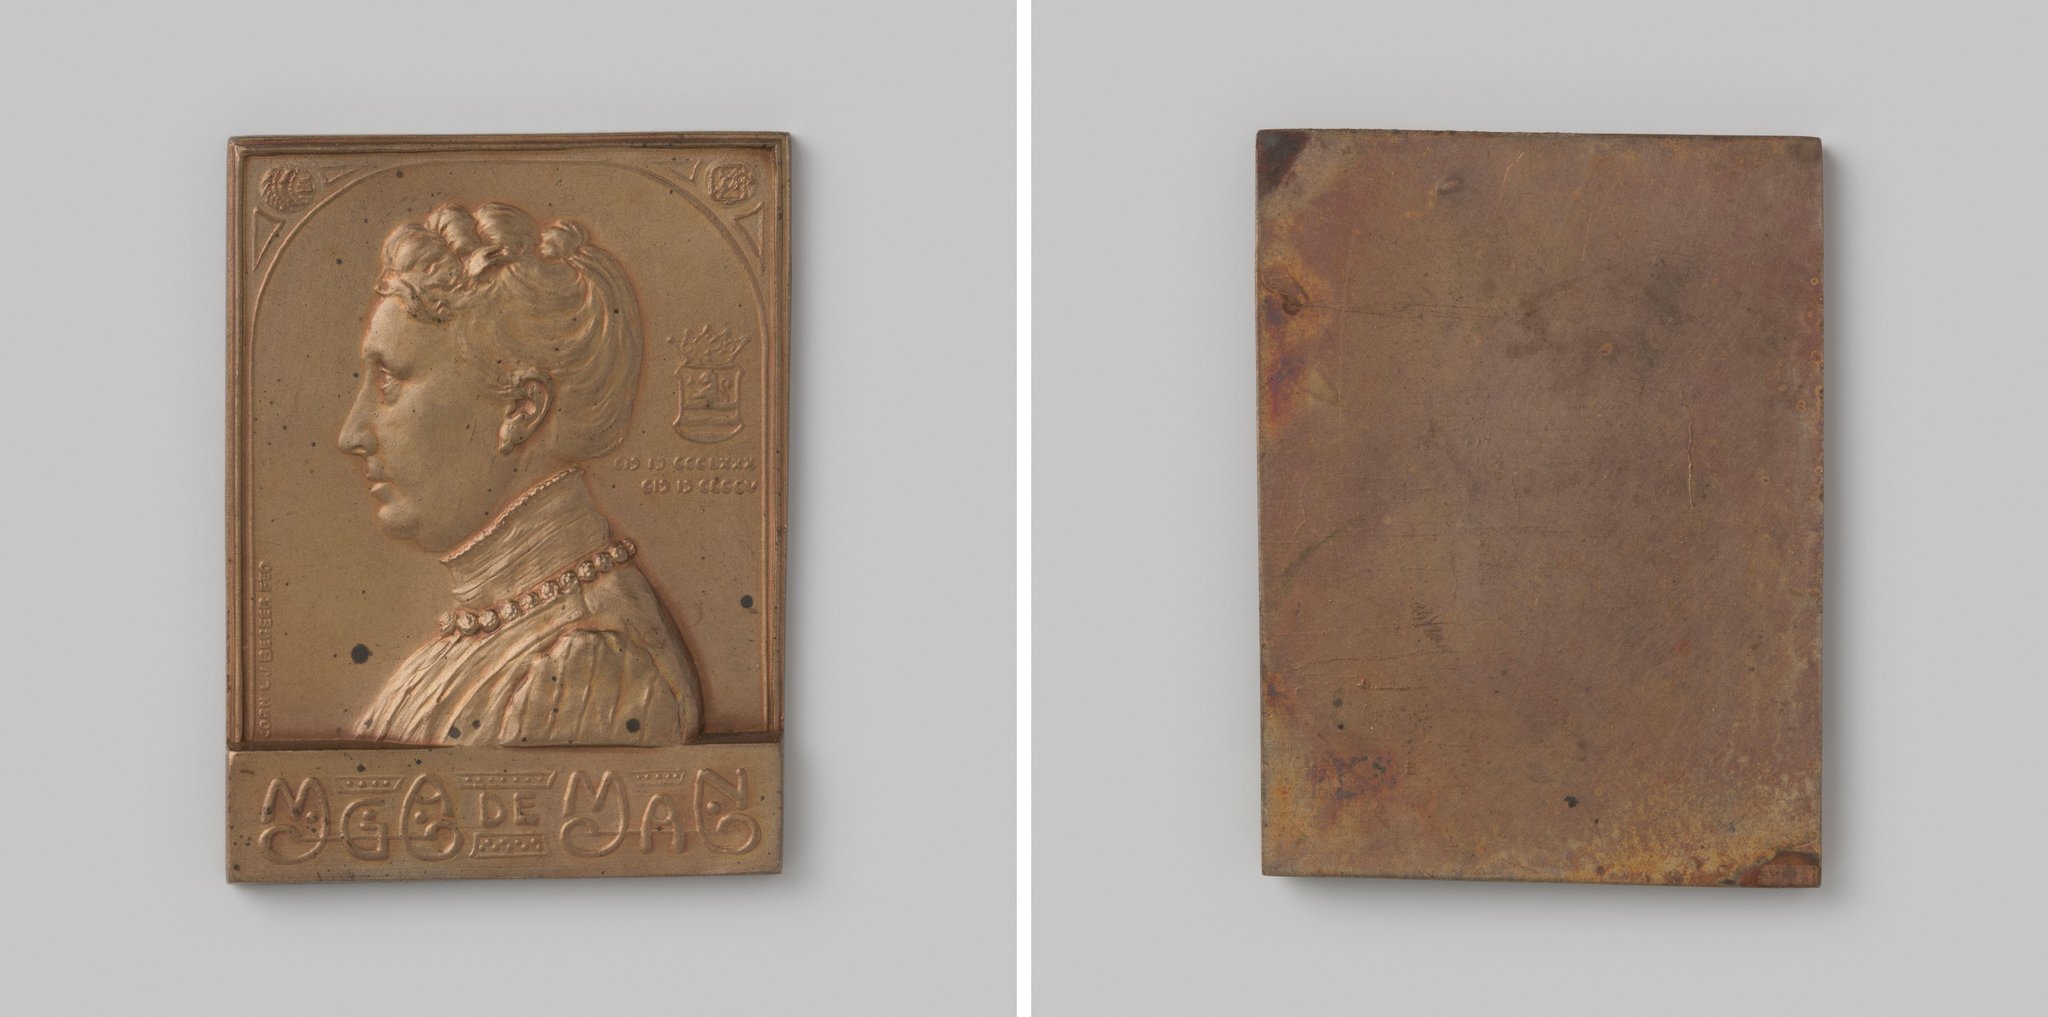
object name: history medal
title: Maria de Man vijfentwintig jaar numismate 1905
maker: cornelis l.j. begeer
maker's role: juwelier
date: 1905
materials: bronze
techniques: striking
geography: utrecht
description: Kleine bronzen eenzijdige plakette met het borstbeeld van De Man naar links, met tekst rechtsboven en op een balk onderaan.